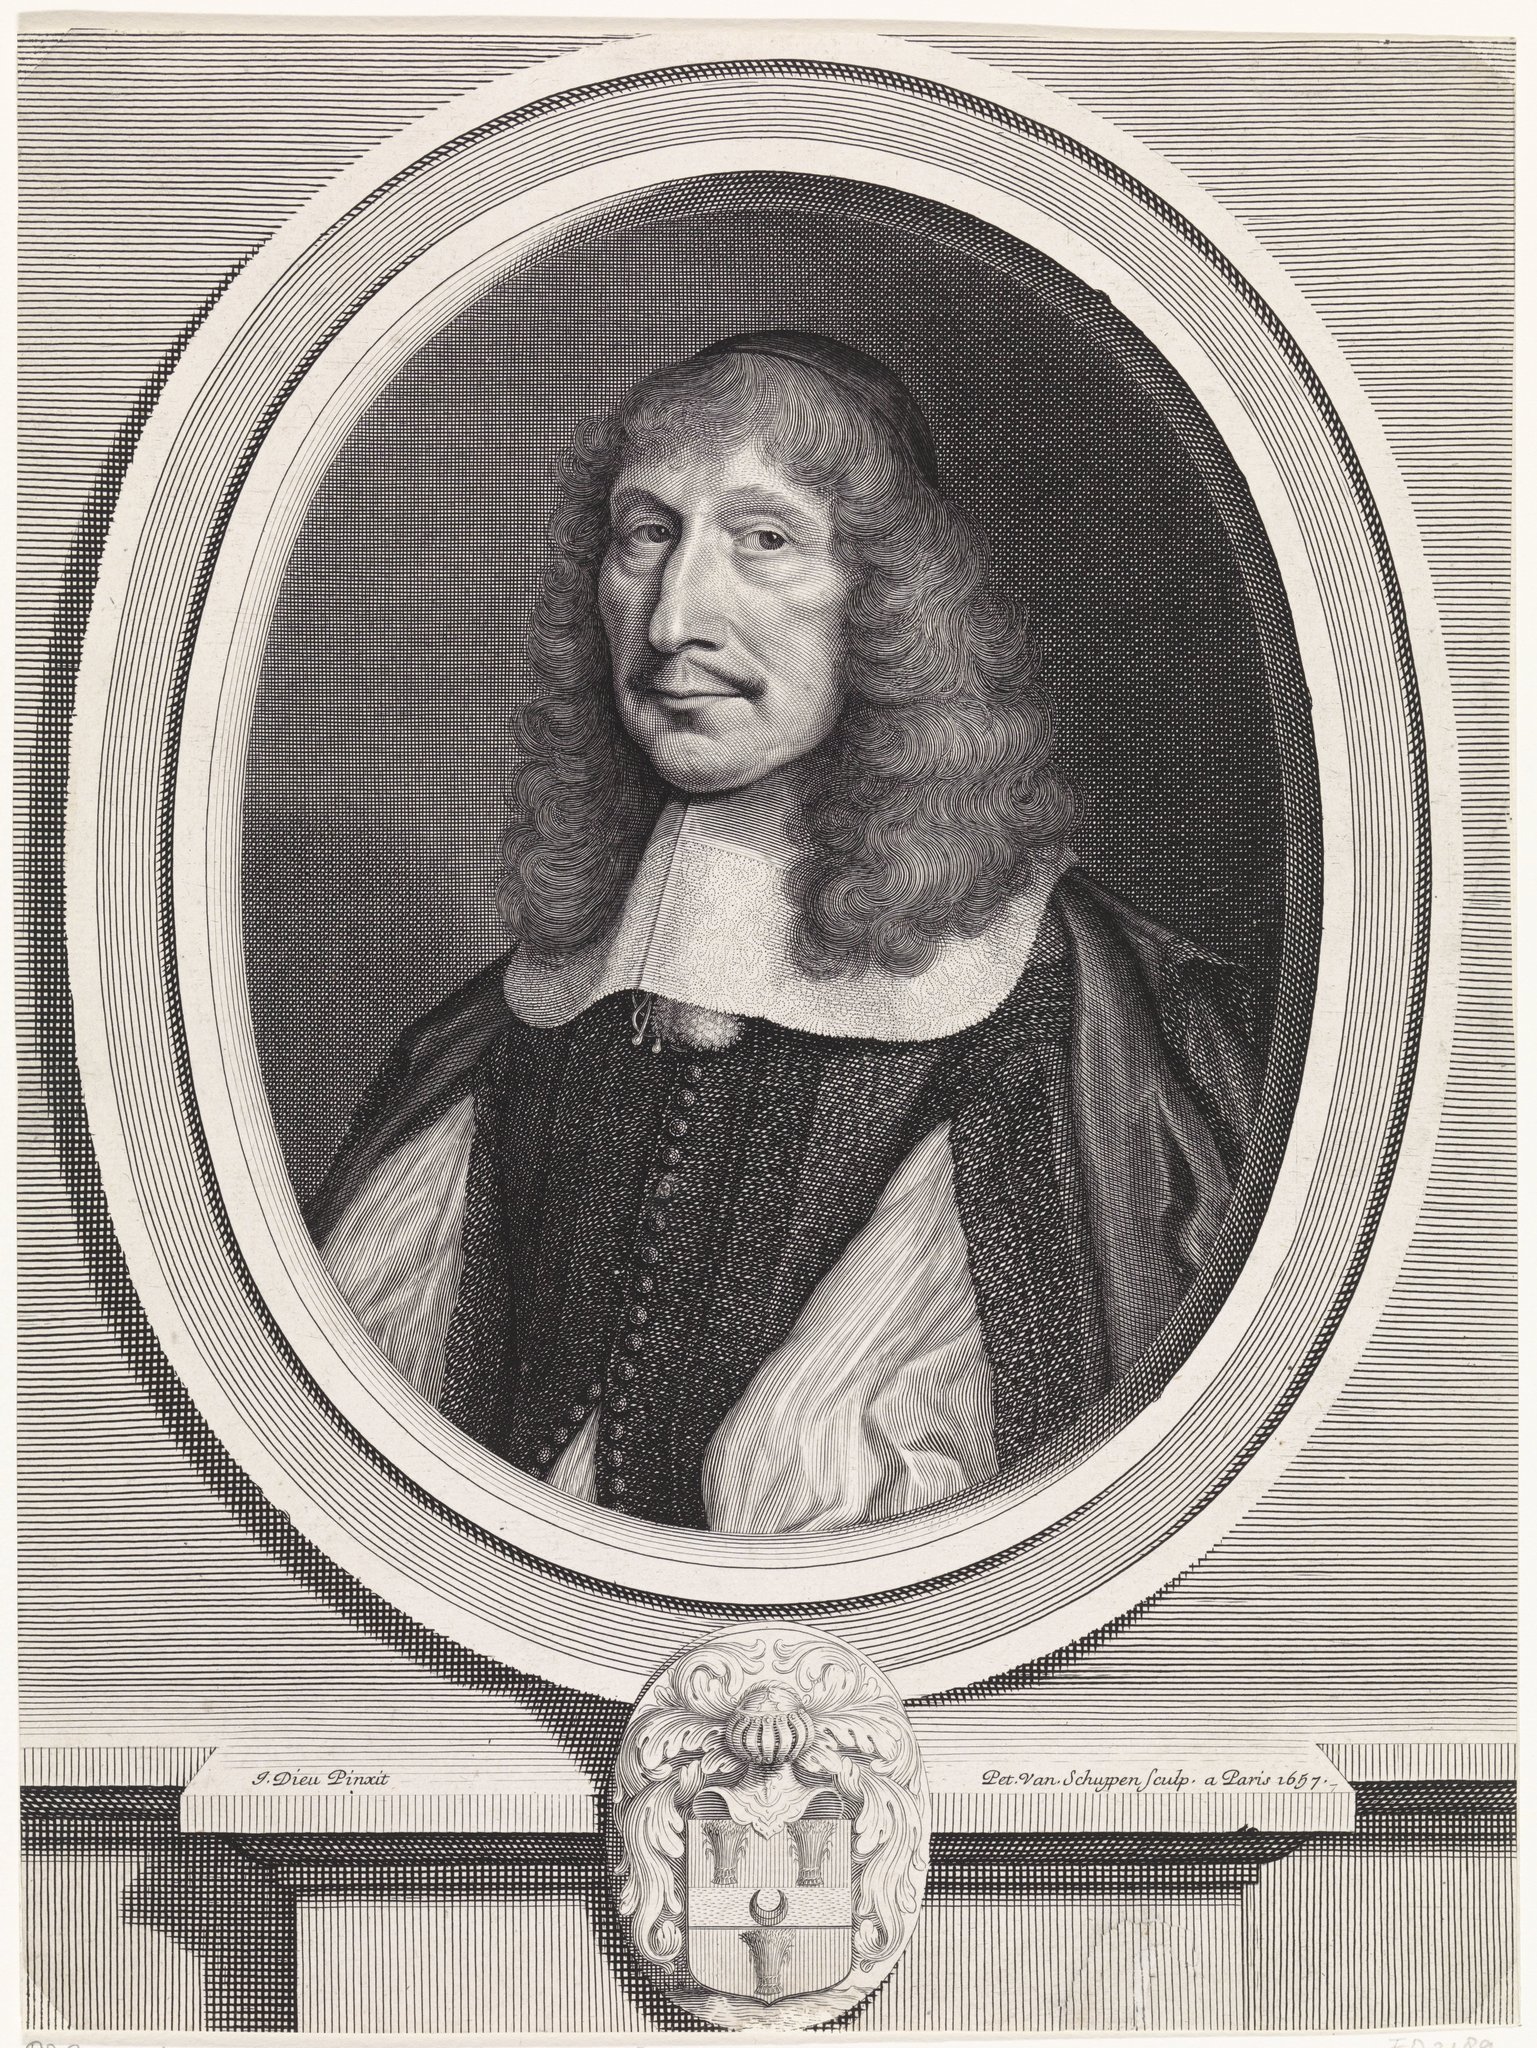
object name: print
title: Portret van Pierre Bordier de Rincy, Intendant des Finances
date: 1607-1657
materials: paper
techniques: engraving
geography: paris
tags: pierre bordier de rincy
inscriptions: collector's mark: Lugt 2228